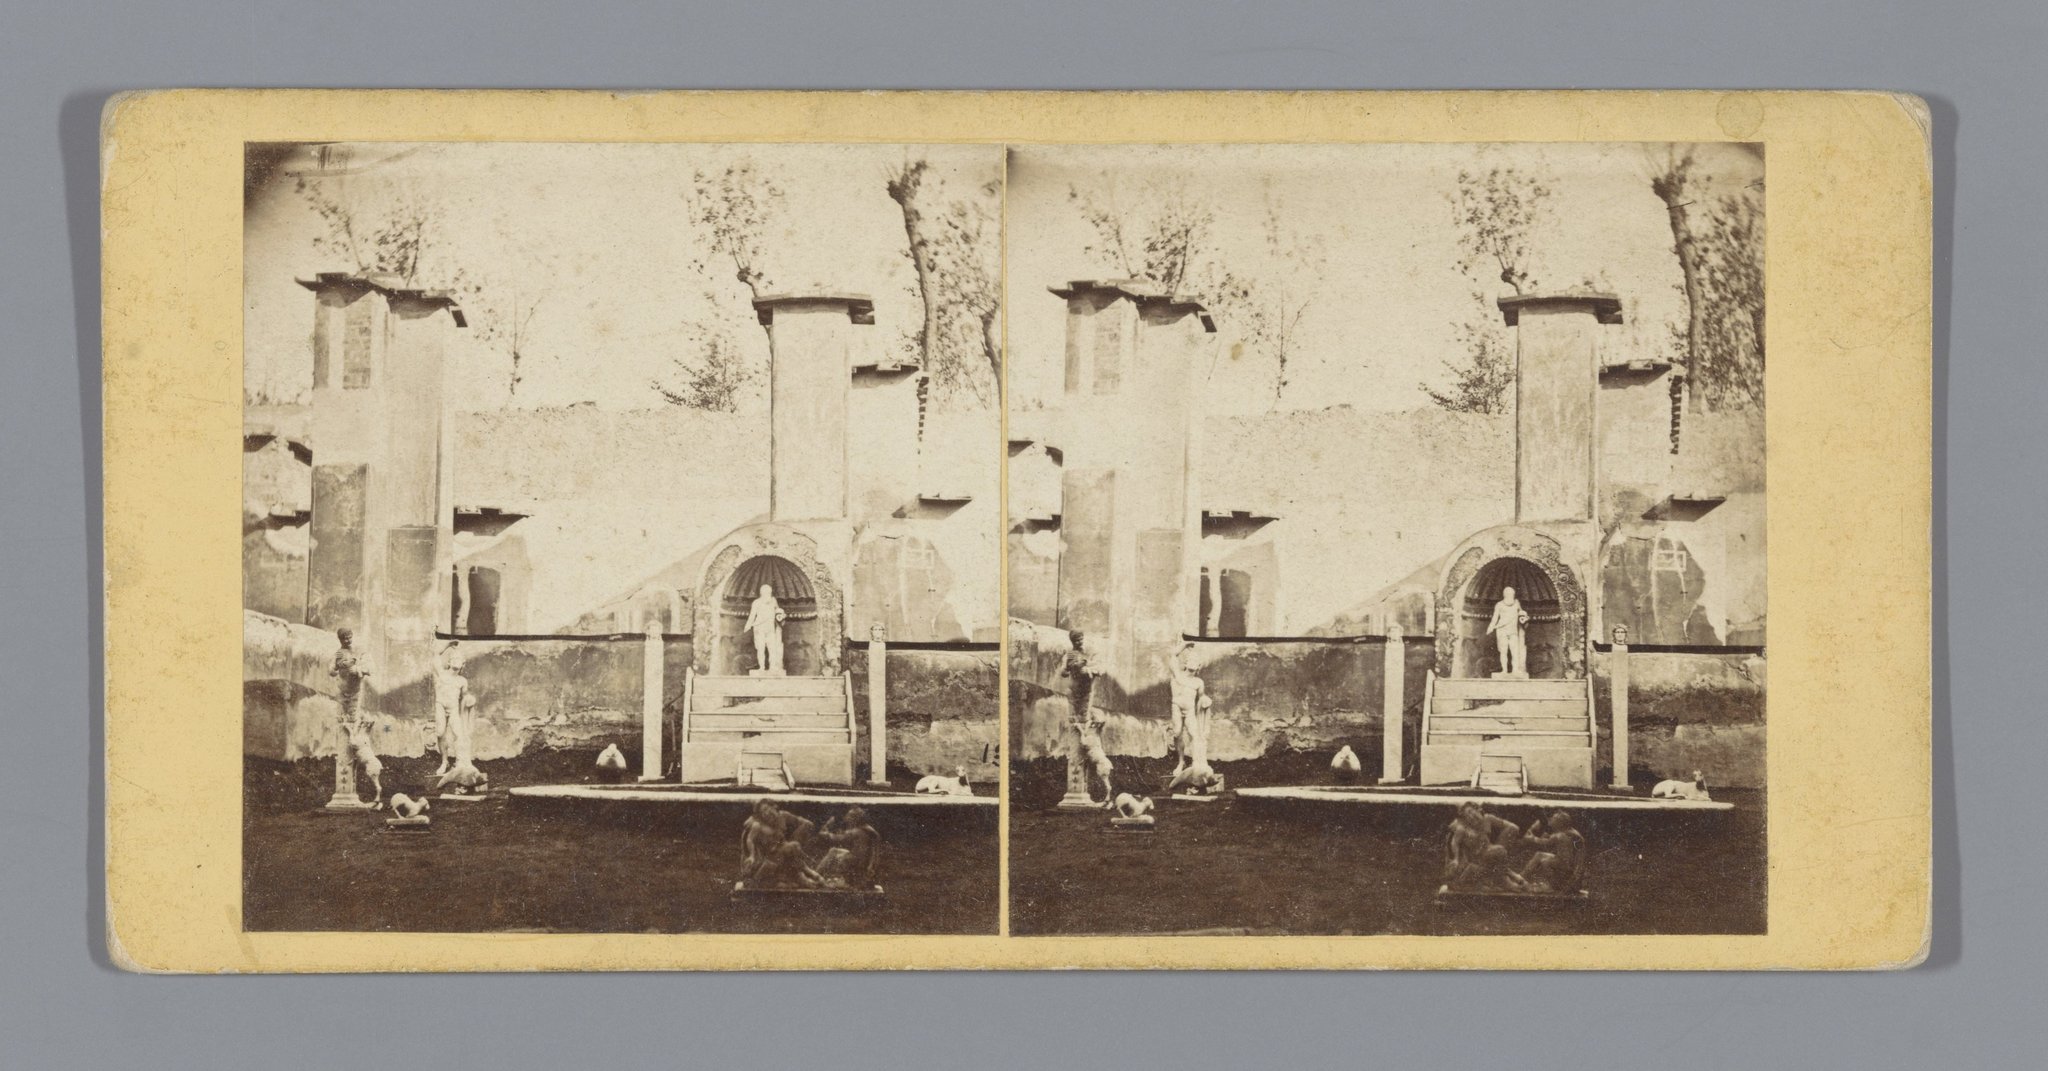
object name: stereograph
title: Interieur van een huis te Pompeï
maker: Anonymous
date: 1850-1880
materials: cardboard, photographic support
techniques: albumen print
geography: pompeii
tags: ruin of a building ~ architecture, sculpture, interior ~ representation of a building, pompeii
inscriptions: inscription: ‘Interieur de la maison des musiciens Pompeï’, number: ‘13’